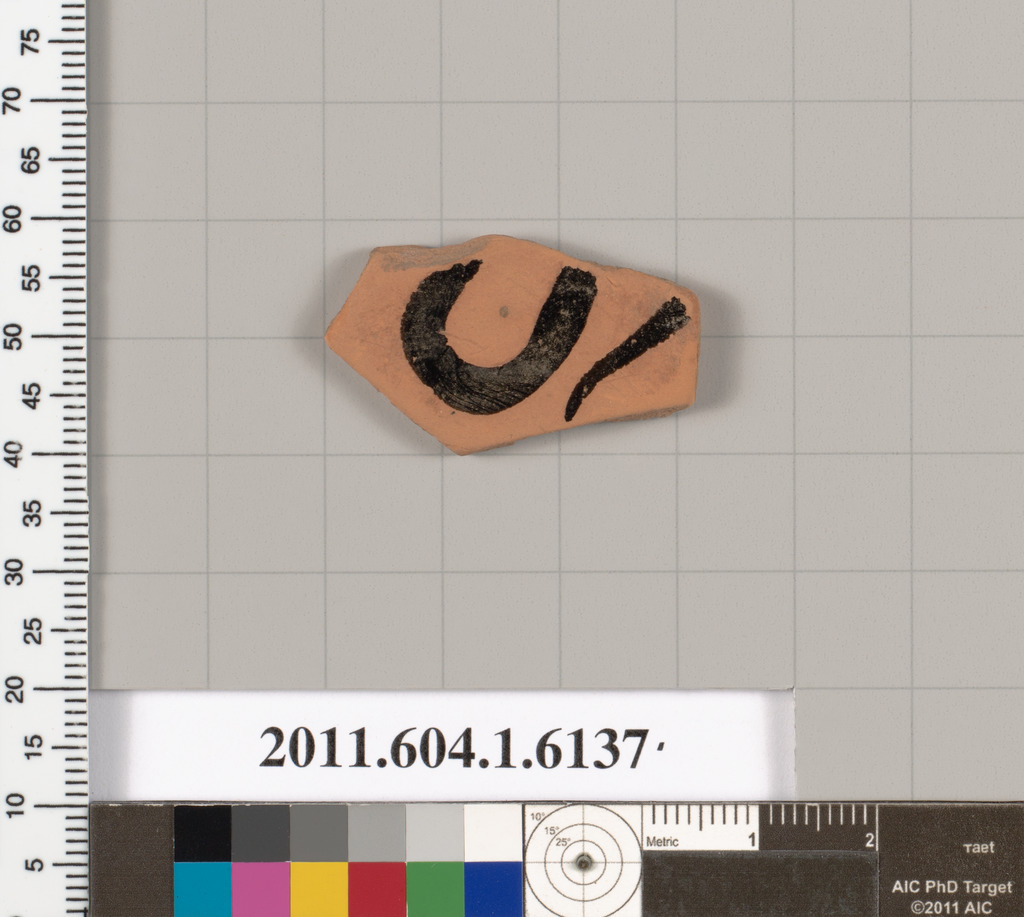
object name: kylix fragment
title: Terracotta fragment of a kylix (drinking cup)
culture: greek, attic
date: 520-500 BCE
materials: terracotta